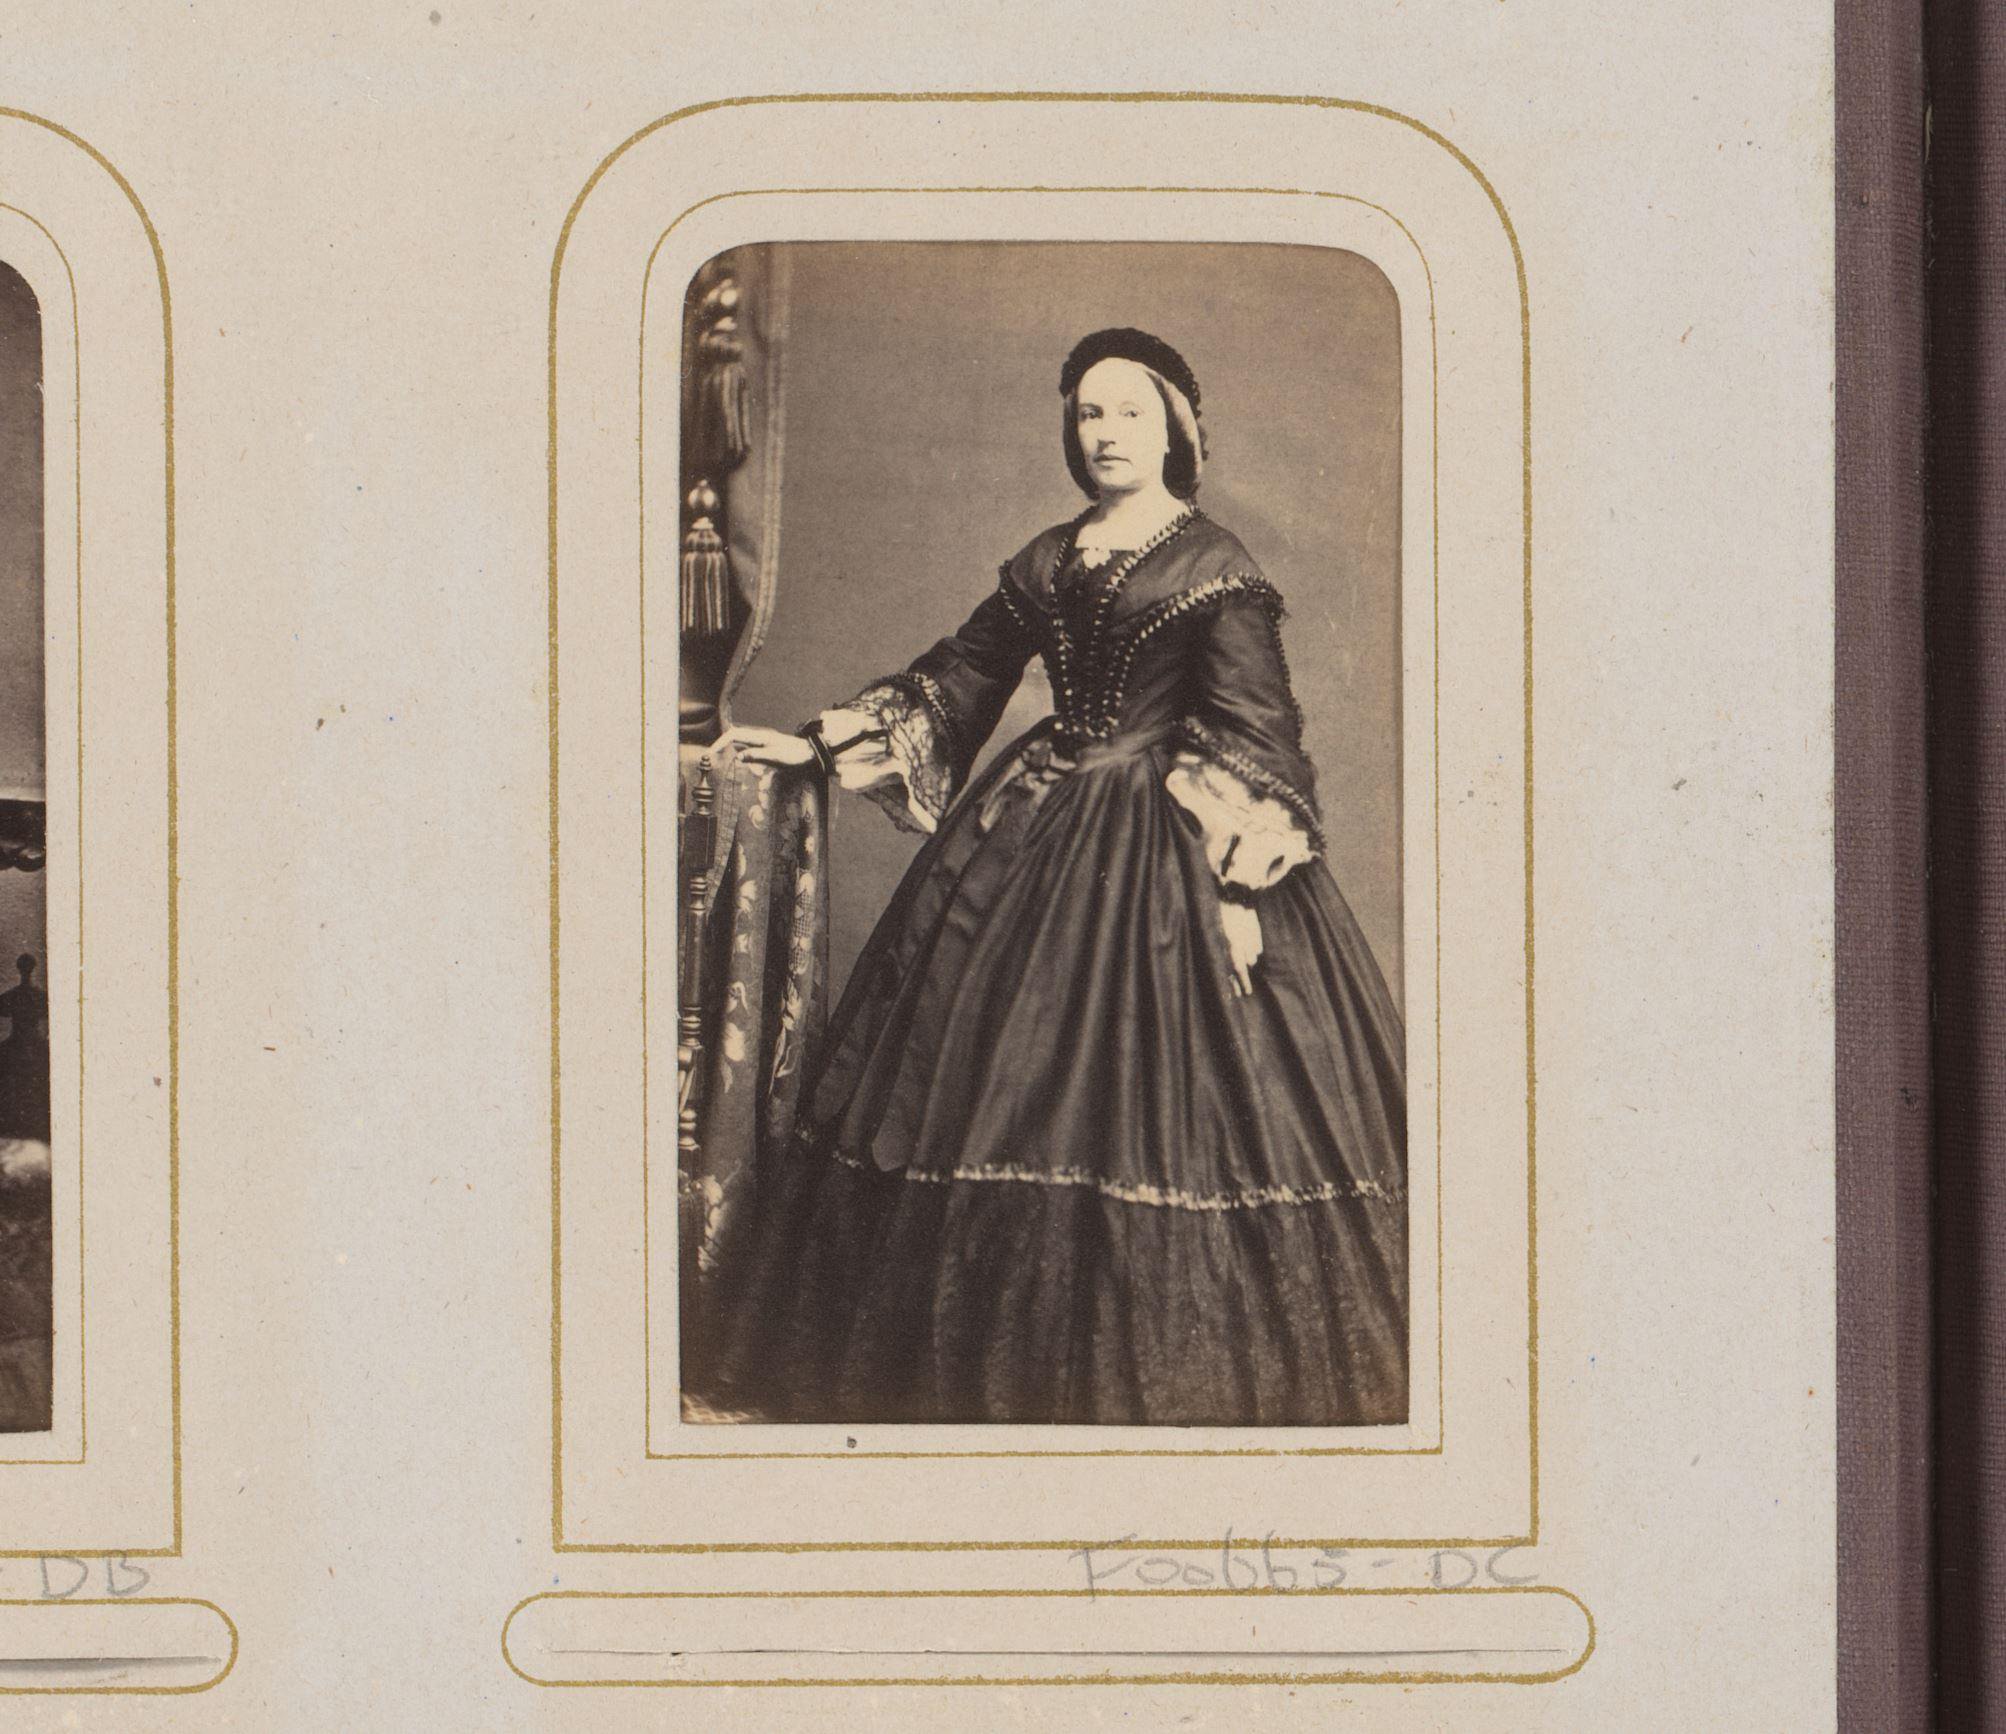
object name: photograph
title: Portret van een vrouw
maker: Anonymous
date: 1855-1880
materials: cardboard, photographic support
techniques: albumen print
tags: historical persons - bb - woman